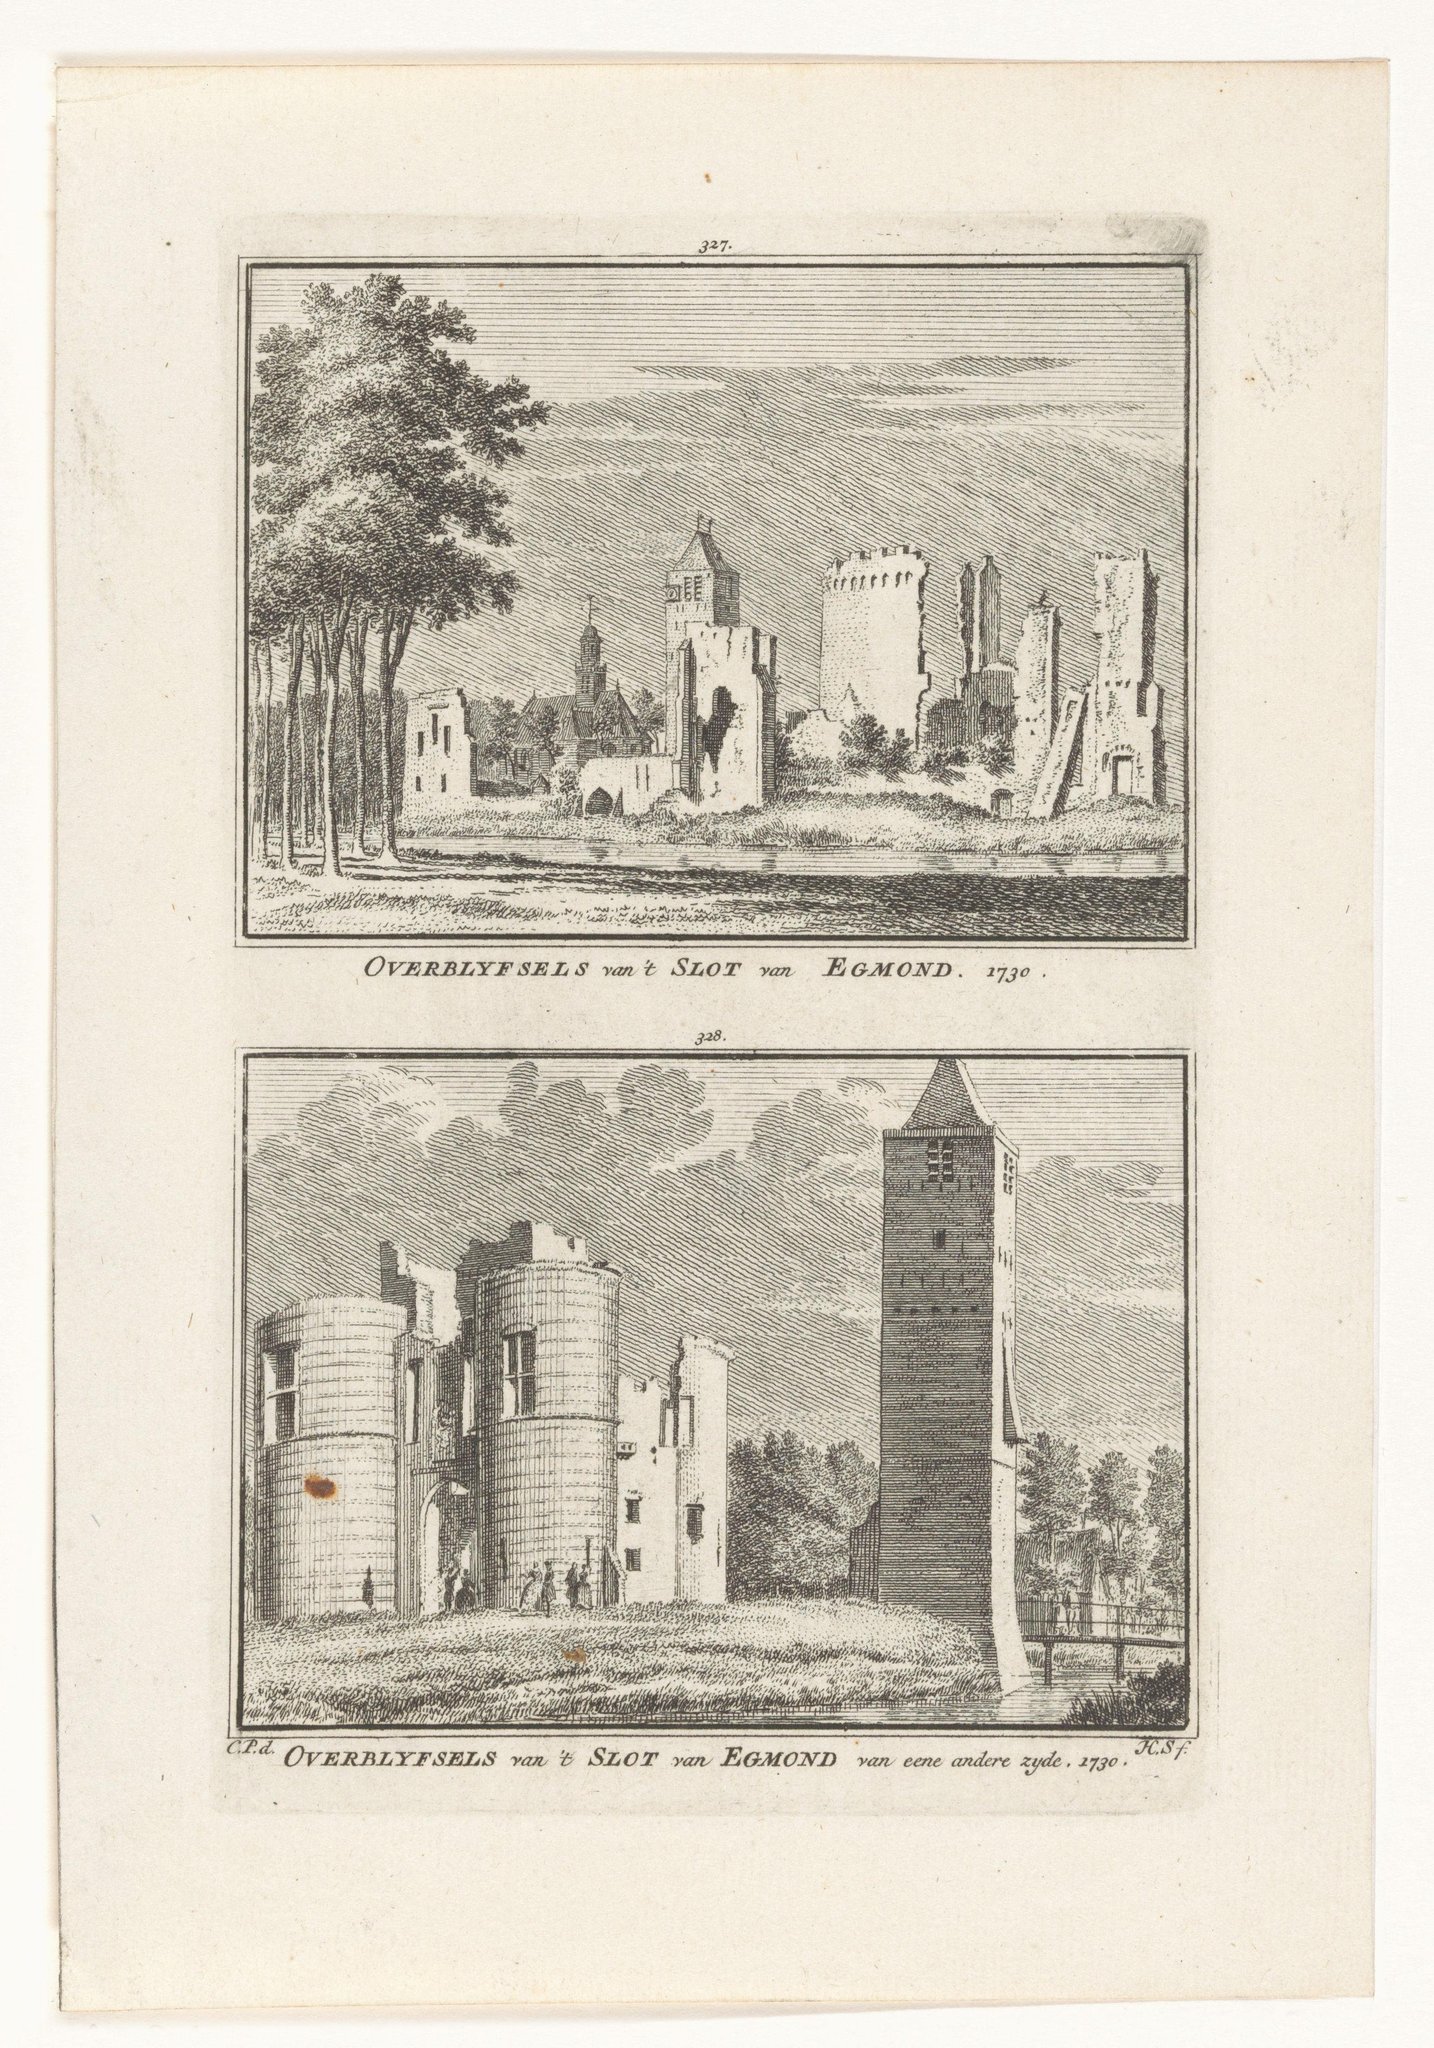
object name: print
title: Overblyfsels van 't Slot van Egmond van eene andere zyde. 1730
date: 1752-1792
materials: paper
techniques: engraving, etching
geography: haarlem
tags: castle, ruin of a dwelling, house, castle, etc.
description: Prent ook gebruikt in: Het verheerlykt Nederland of kabinet van hedendaagsche gezigten van steden, dorpen (…). 9 delen. Amsterdam: Isaak Tirion en weduwe Isaak Tirion, 1745-1774, dl. 4 (1752), ill. 327 en 328. Of in: Nederlandsche tafereelen; of eene keurige verzameling van negen honderd fraaije gezigten van steden, dorpen, sloten, oudheden (….). 9 delen. Amsterdam: Jan de Groot, 1792, dl. 4, ill. 327 en 328. Uit welke druk het huidige exemplaar precies komt is niet na te gaan.